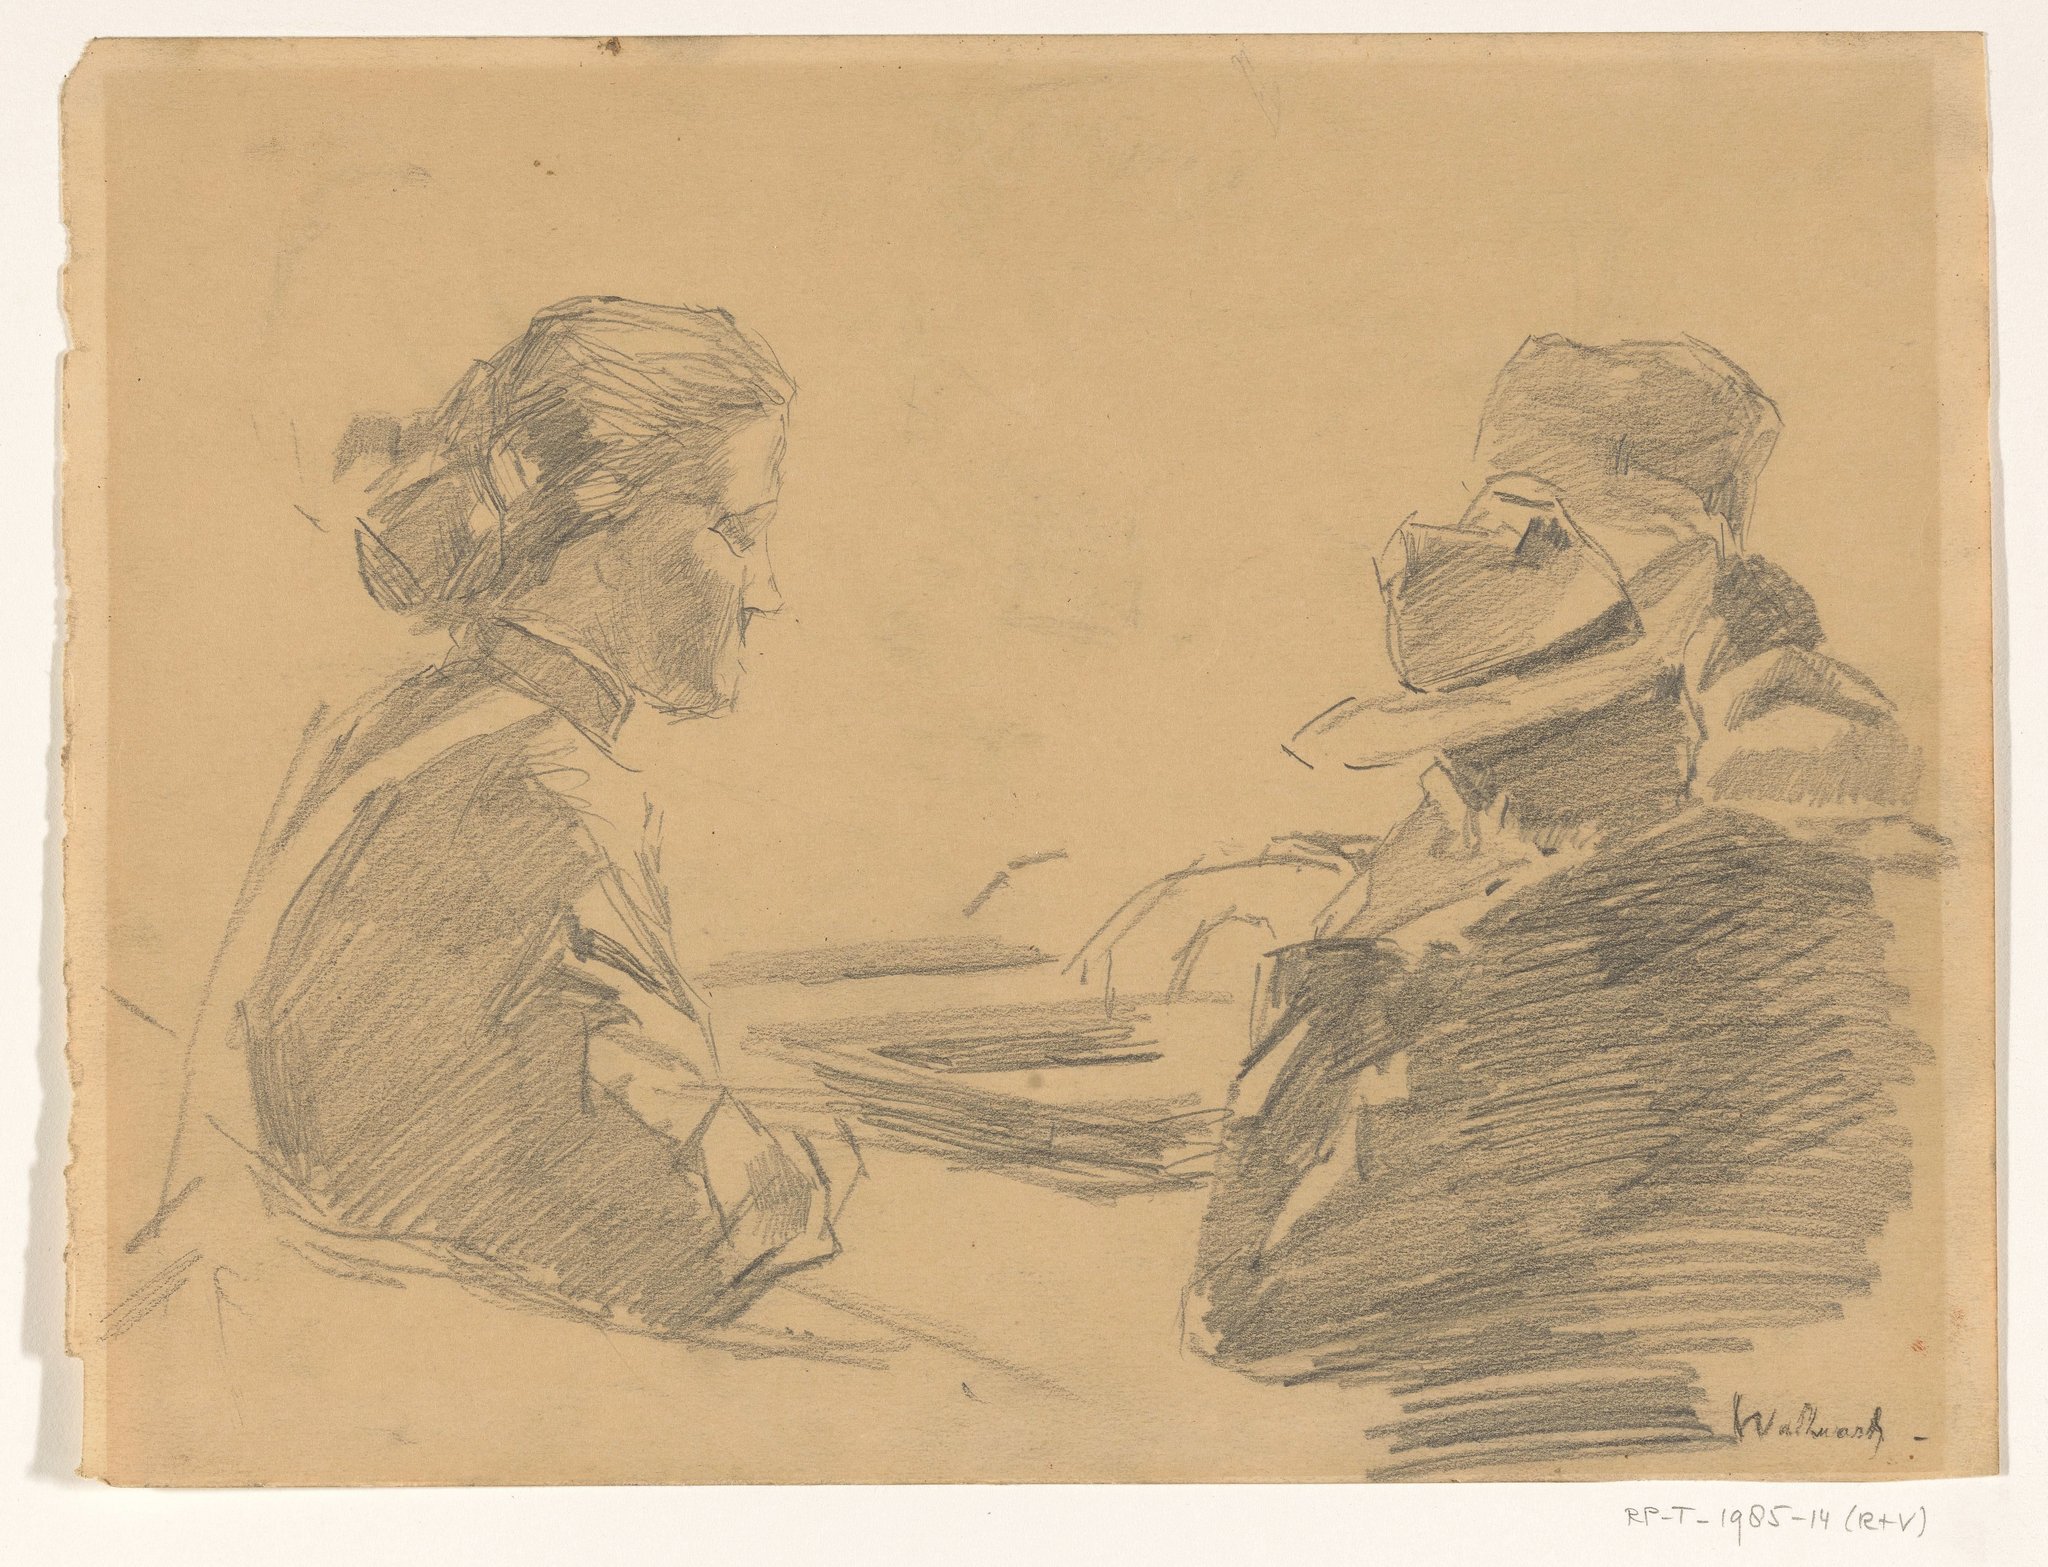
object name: drawing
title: Drie zittende figuren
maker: willem de zwart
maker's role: draughtsman, painter, print maker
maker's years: 1862-1931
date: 1872-1931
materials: paper, pencil